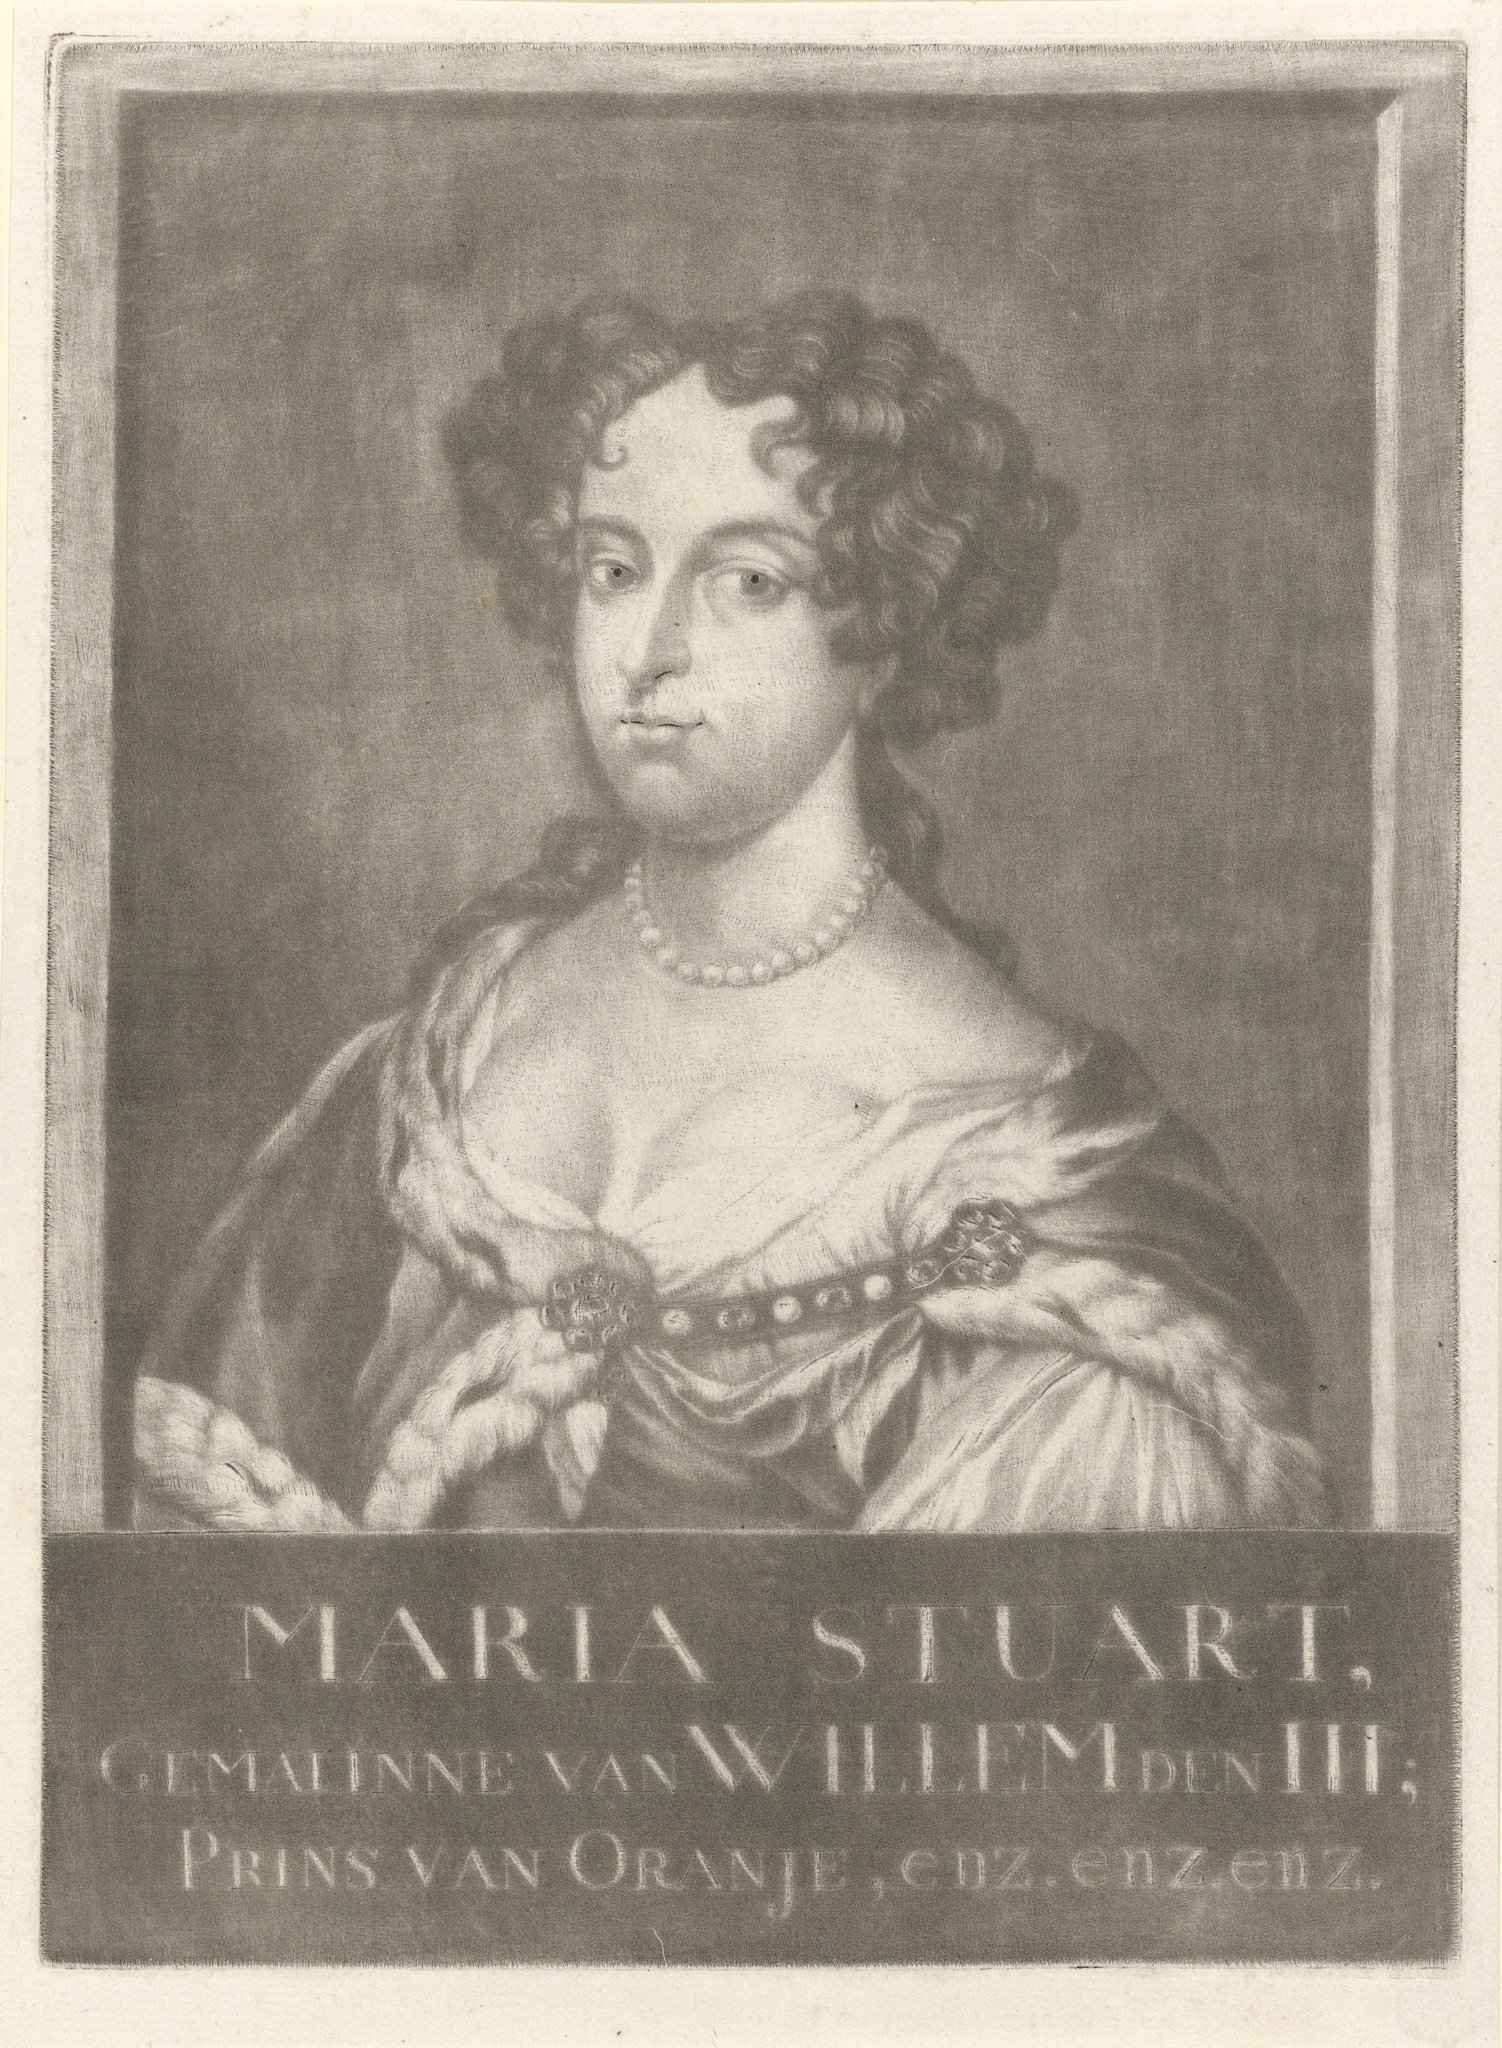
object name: book illustration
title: Portret van Maria II Stuart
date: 1770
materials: paper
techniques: mezzotint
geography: leeuwarden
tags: london, maria ii stuart (koningin van engeland, schotland en ierland)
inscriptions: collector's mark: Lugt 963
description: De hier vermelde titel verwijst naar de hoogst verkregen titel van de geportretteerde, niet per se naar de titel die de geportretteerde op deze voorstelling draagt. Prent uit: Bosch, Johannes van den. De heeren stadhouderen van Vriesland, zedert den jare acht-hondert, volgens hoogst derzelver successie kortelyk beschreven. Leeuwarden: Abraham Ferwerda en Gerrit Tresling, 1770.